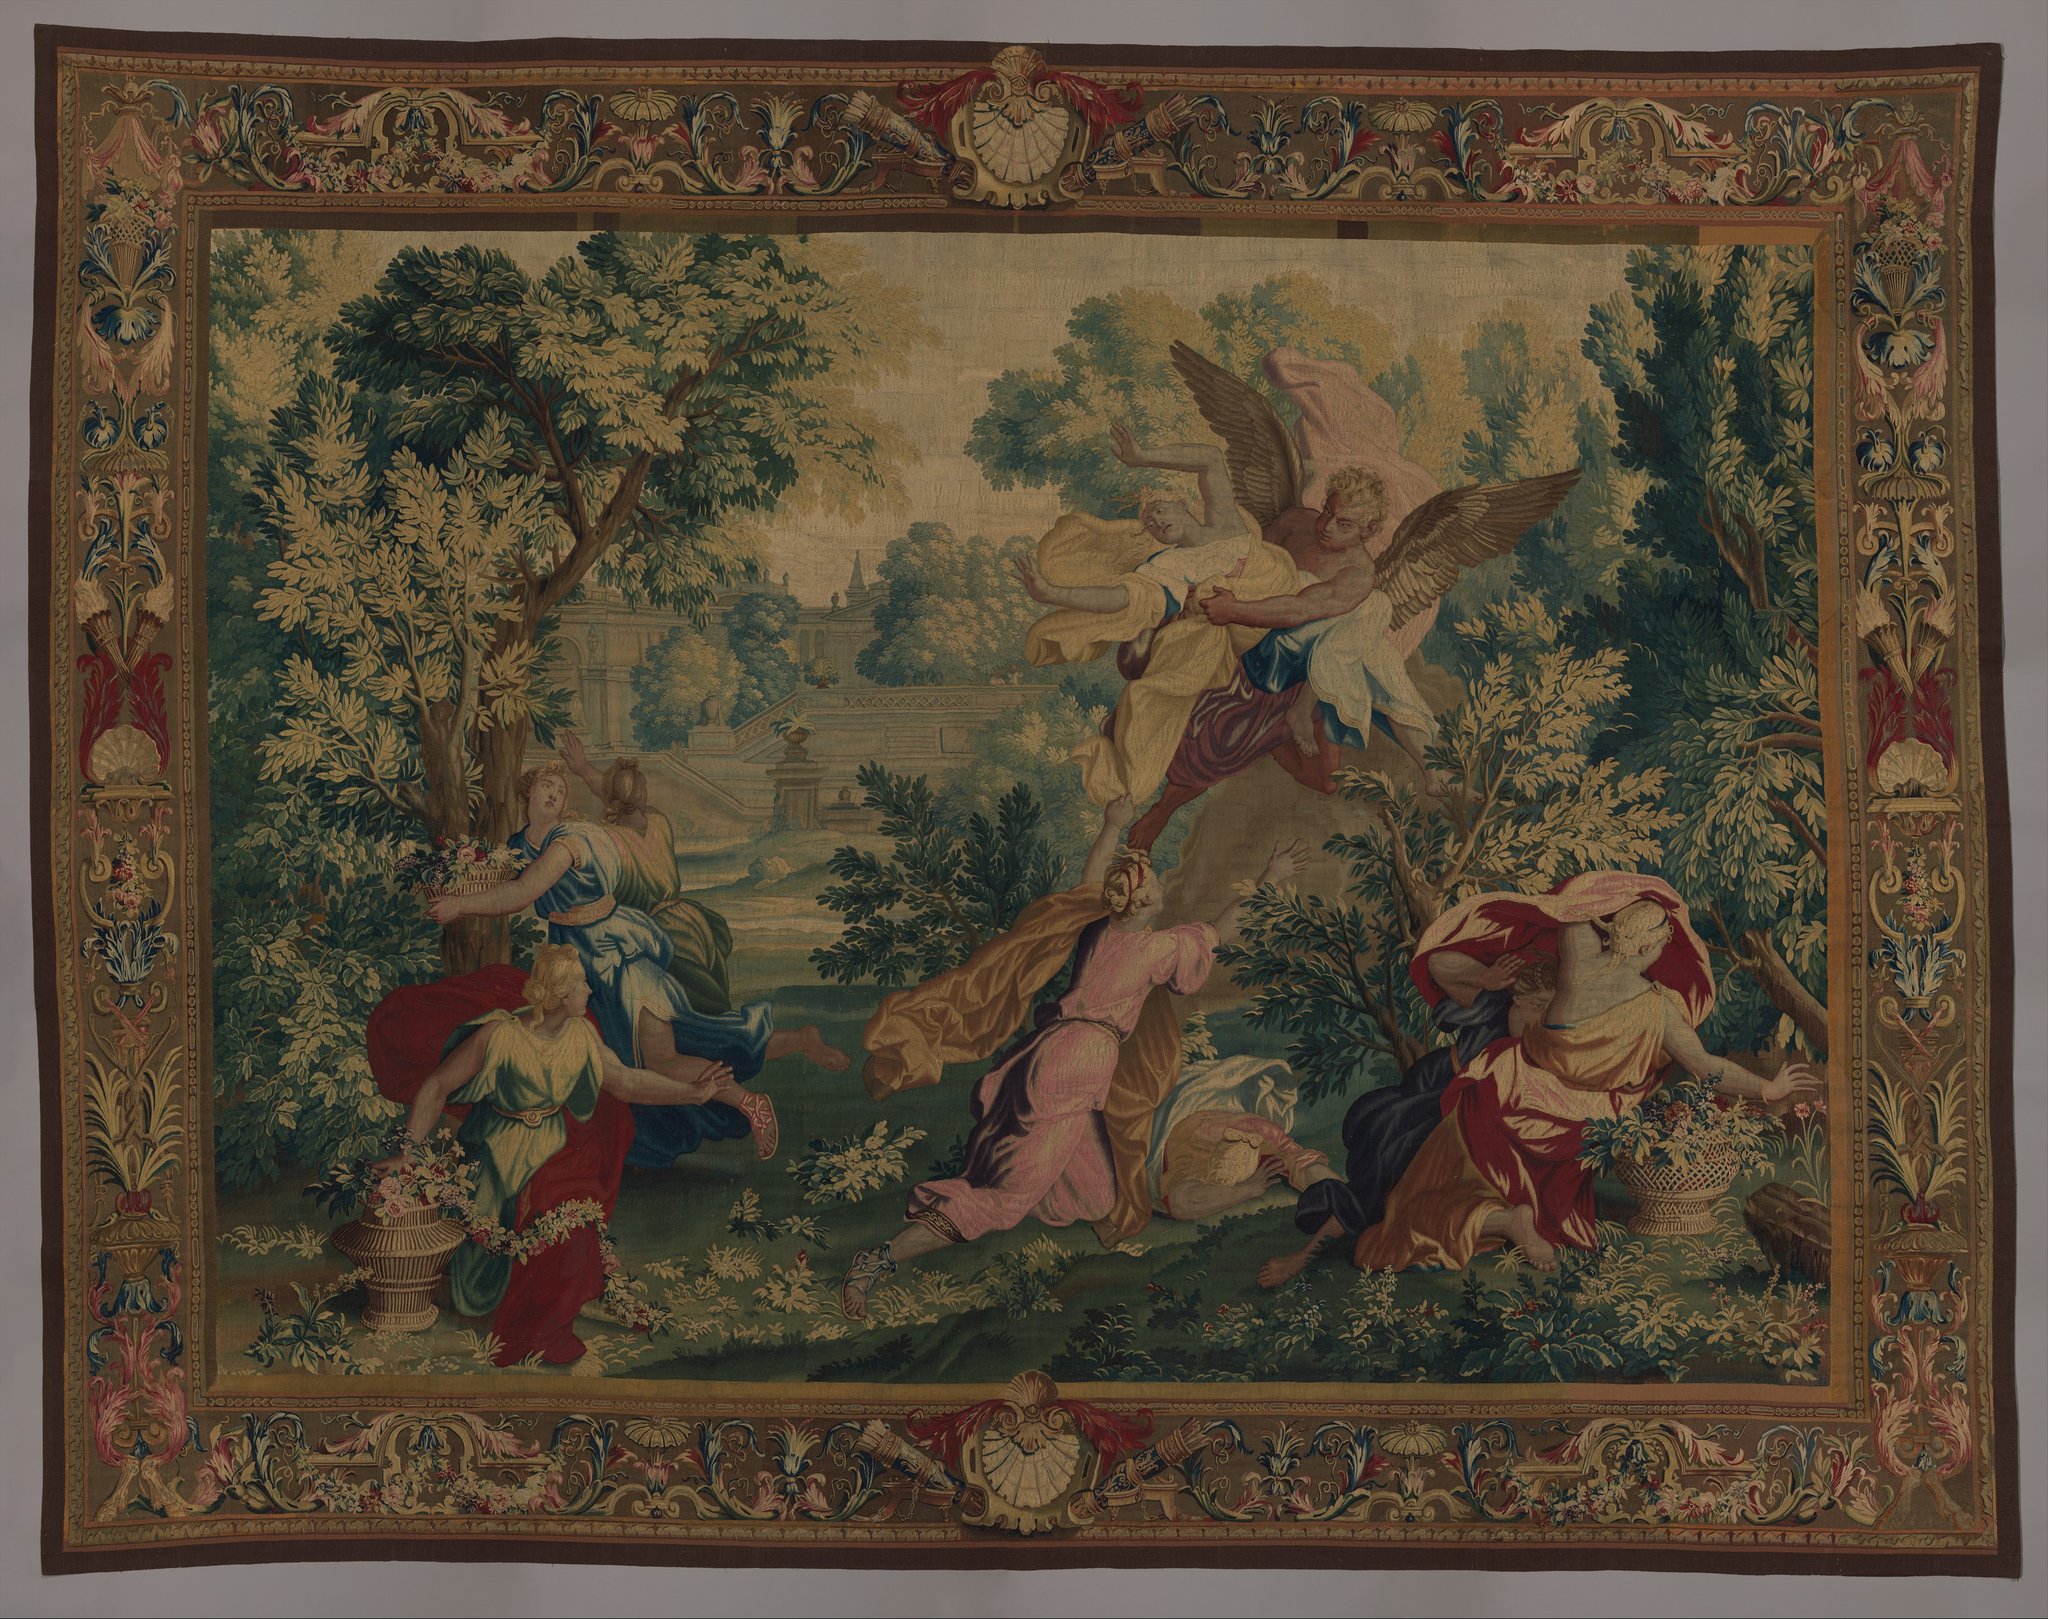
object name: tapestry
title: Boreas and Orithyia from a set of scenes from Ovid's Metamorphoses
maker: rené antoine houasse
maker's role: designer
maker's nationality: french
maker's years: 1645-1710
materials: metal thread, silk, wool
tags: men,women,trees